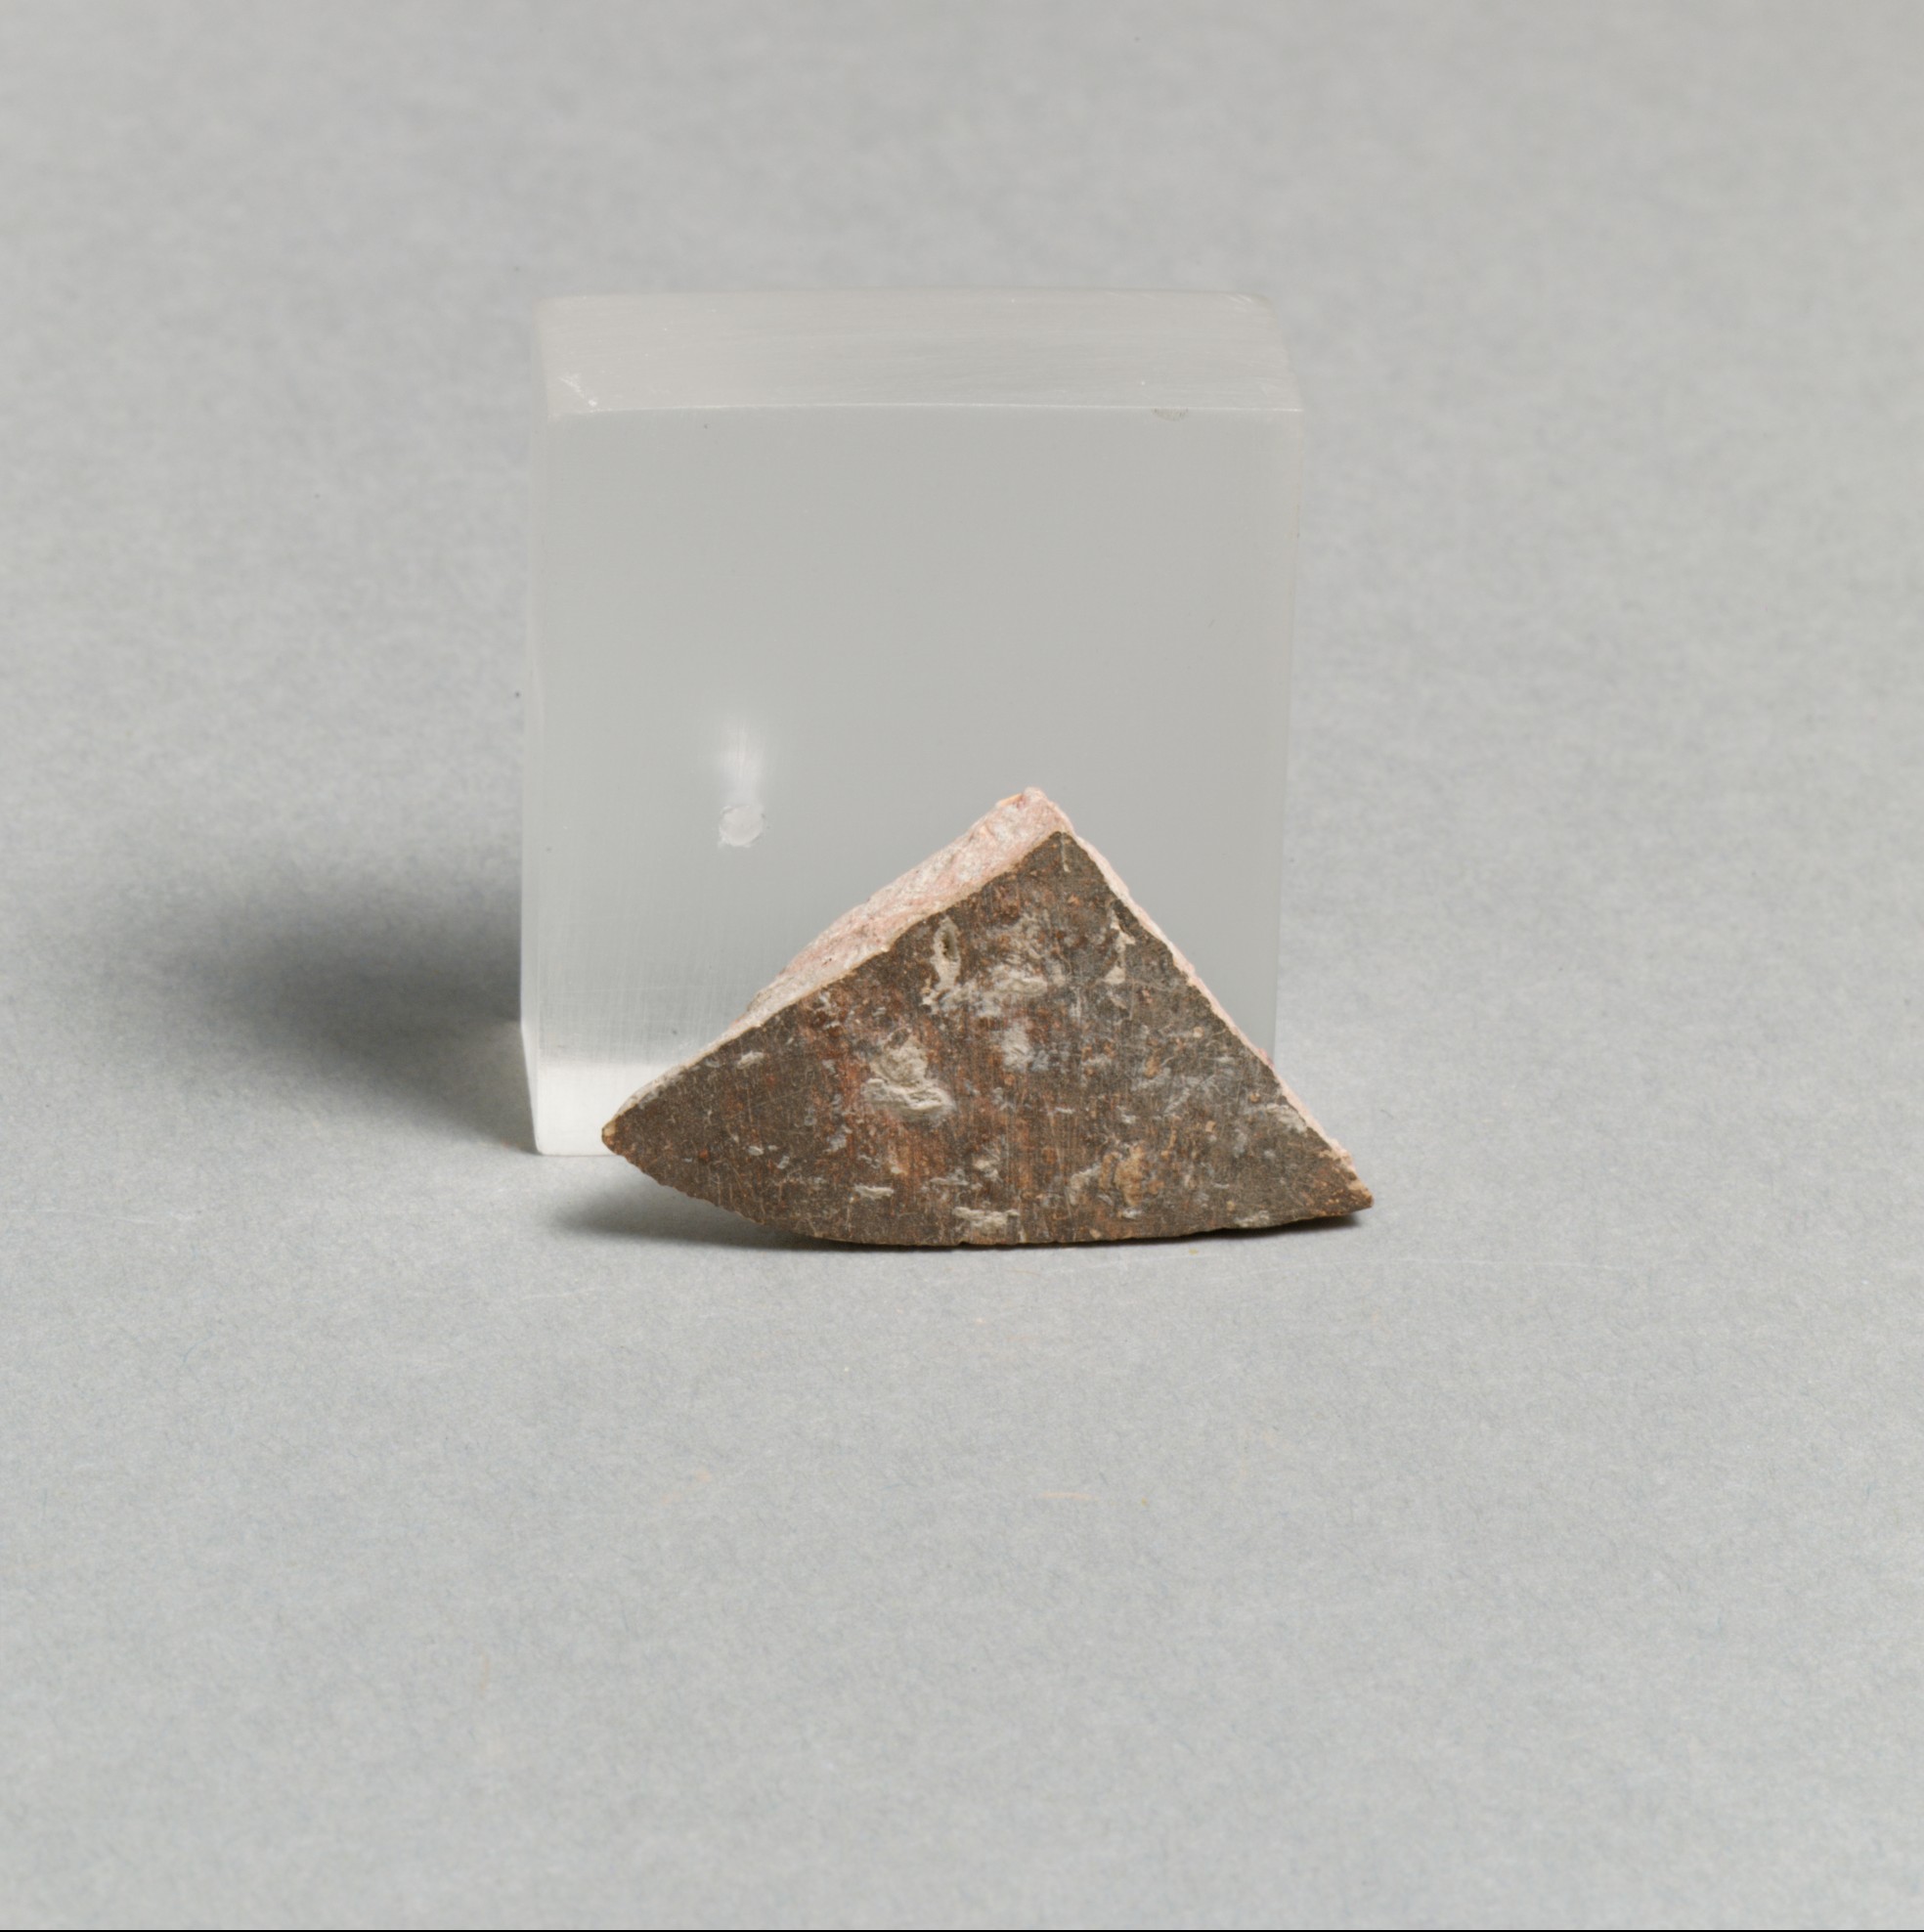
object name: vase fragment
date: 3000-2200 BCE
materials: terracotta